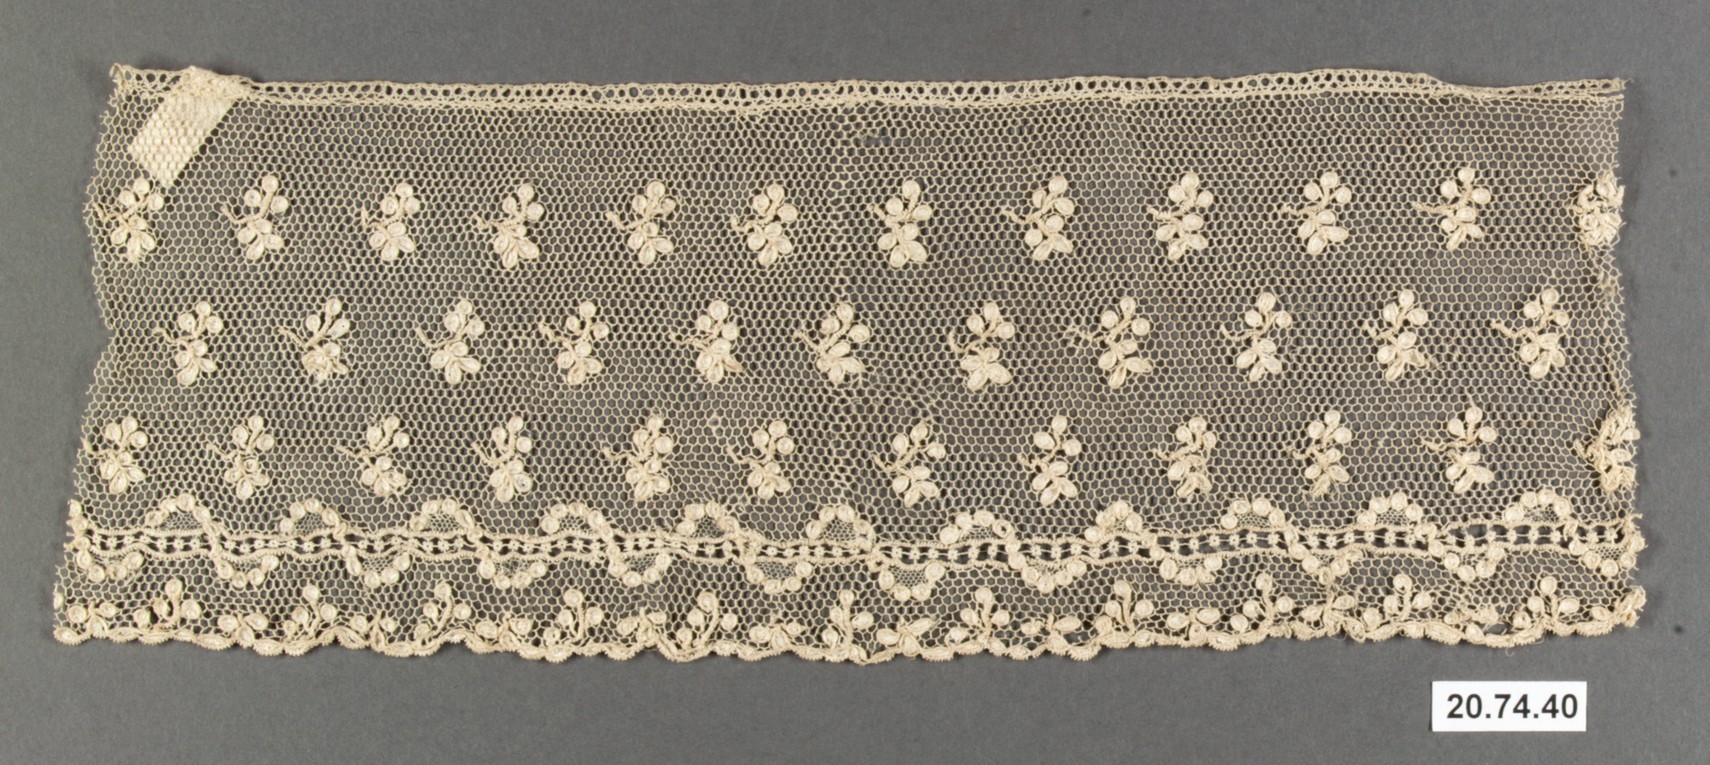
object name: fragment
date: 1776-1800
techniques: lace